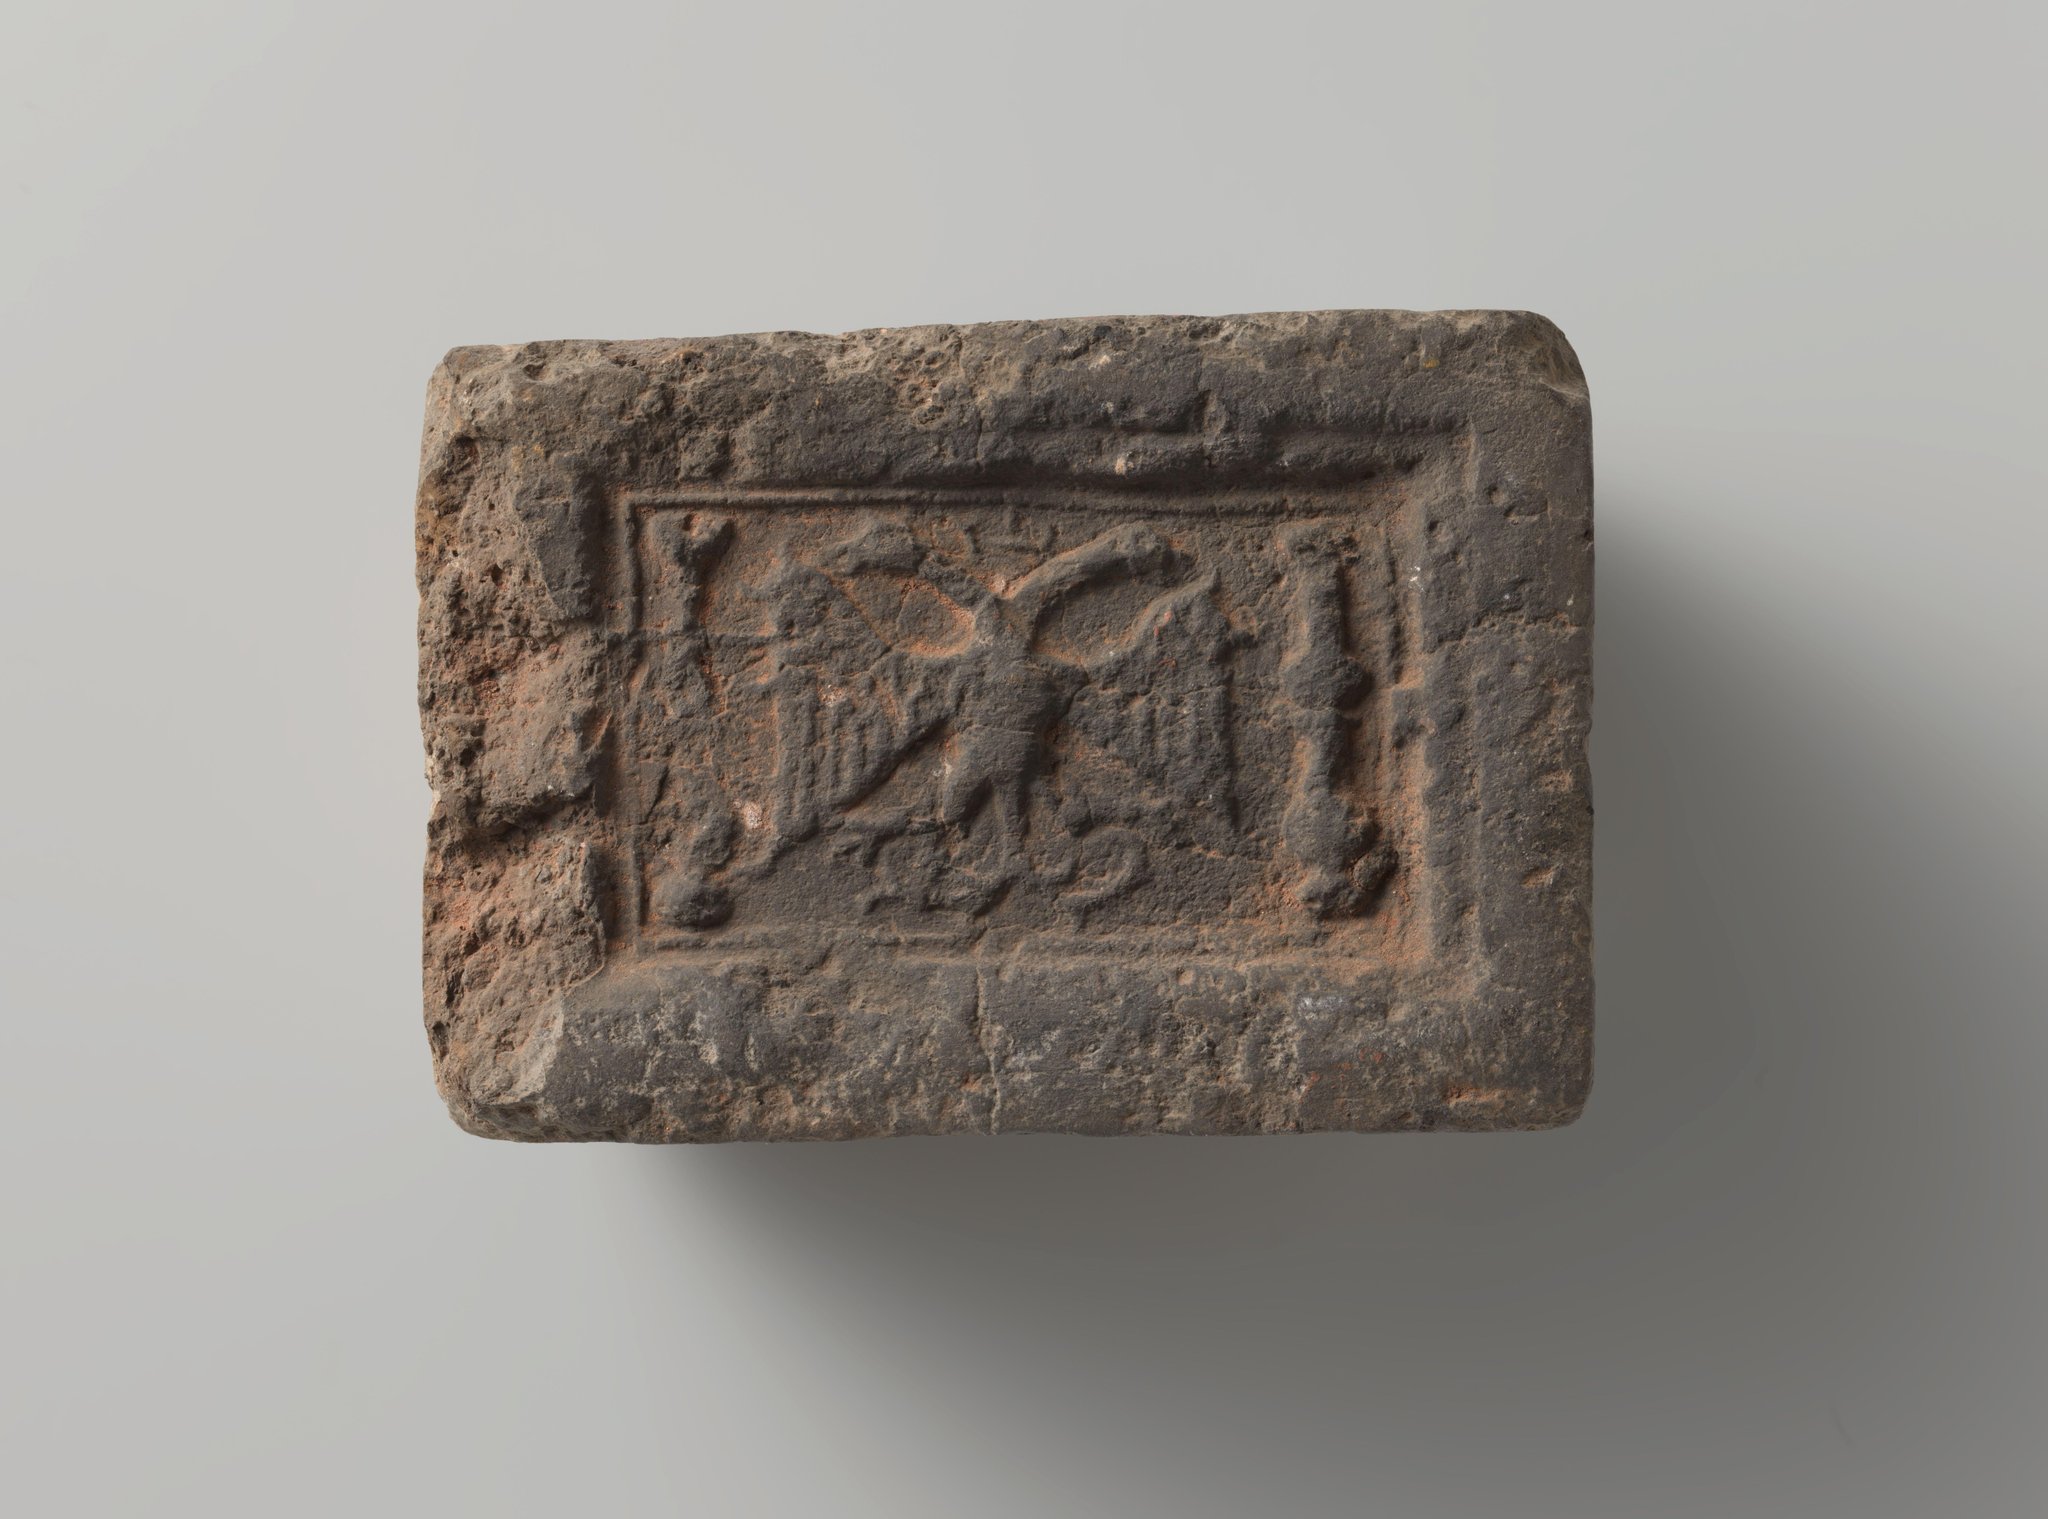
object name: haarddeksteen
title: Haarddeksteen met een dubbelkoppige adelaar en twee zuilen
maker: Anonymous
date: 1500-1558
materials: brick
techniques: printing, firing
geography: southern netherlands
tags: ghent, charles v (holy roman emperor and king of spain)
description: Frontonvormige haardsteen met wapen van Karel V van Habsburg; gekroond schild met tweekoppige adelaar met schild op de borst, aan weerszijden zuilen, links met griffioen rechts met leeuw, om zuilen en achter schild banderol met opschrift: PLUS OLTRE, in fronton gekroond hoofd en 15.2, rechter dakrand afgebrokkeld, zwart geblakerd, erg afgesleten, rechter kant breuklijn, punt frontonmet resten cement. (Deze beschrijving is ten onrechte toegekend aan dit nummer. B. Nederveen en J.D. van Dam, 2008-01-24.)